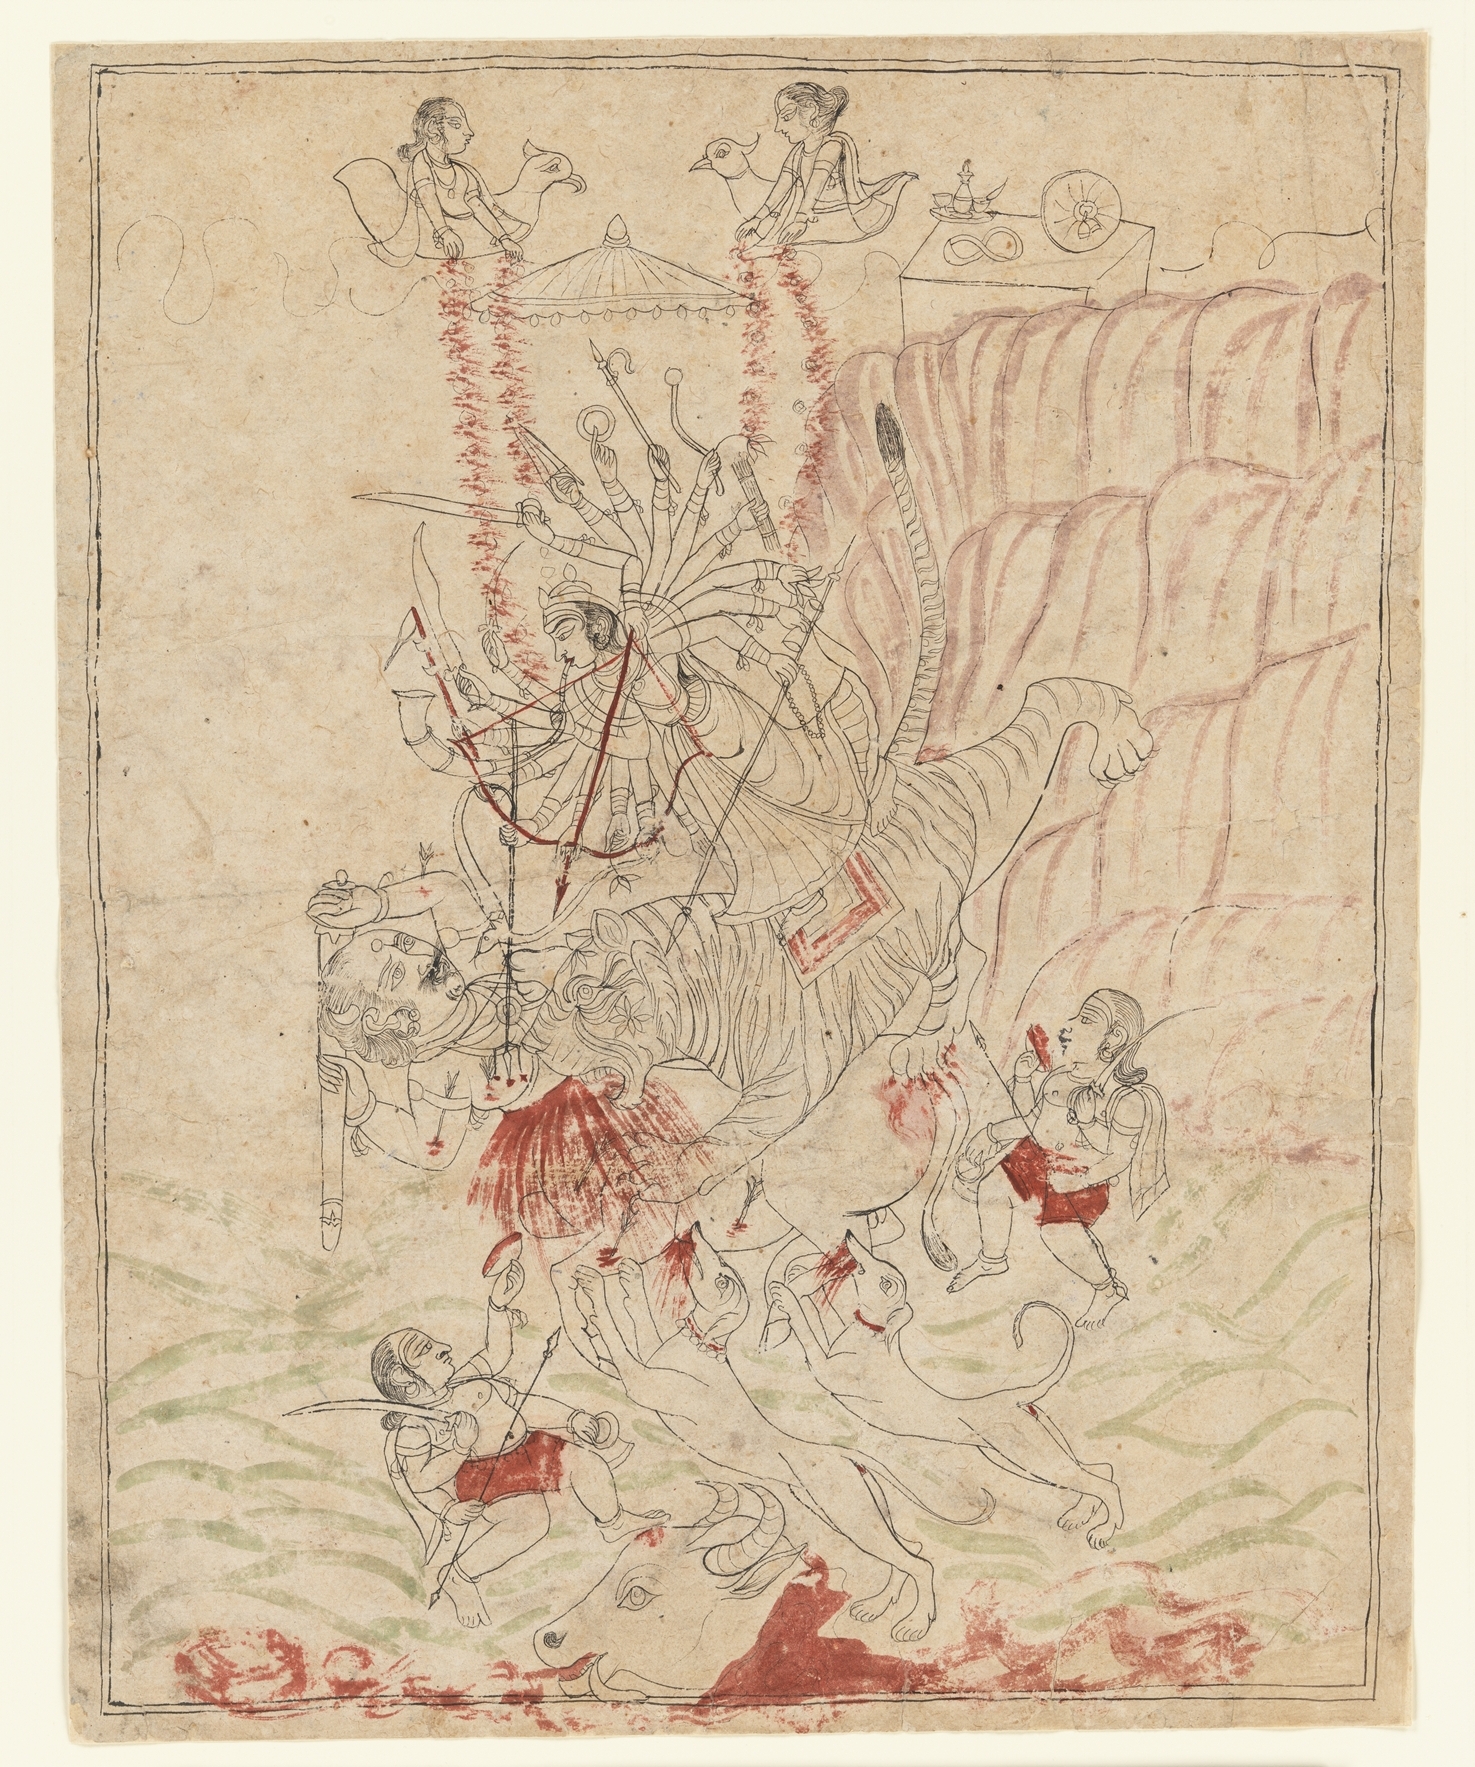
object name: painting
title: The Goddess Durga Killing the Buffalo Demon, Mahisha (Mahishasura Mardini)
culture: mewar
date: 1760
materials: ink, paper, watercolor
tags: dogs,tigers,demons,goddess,durga,hinduism